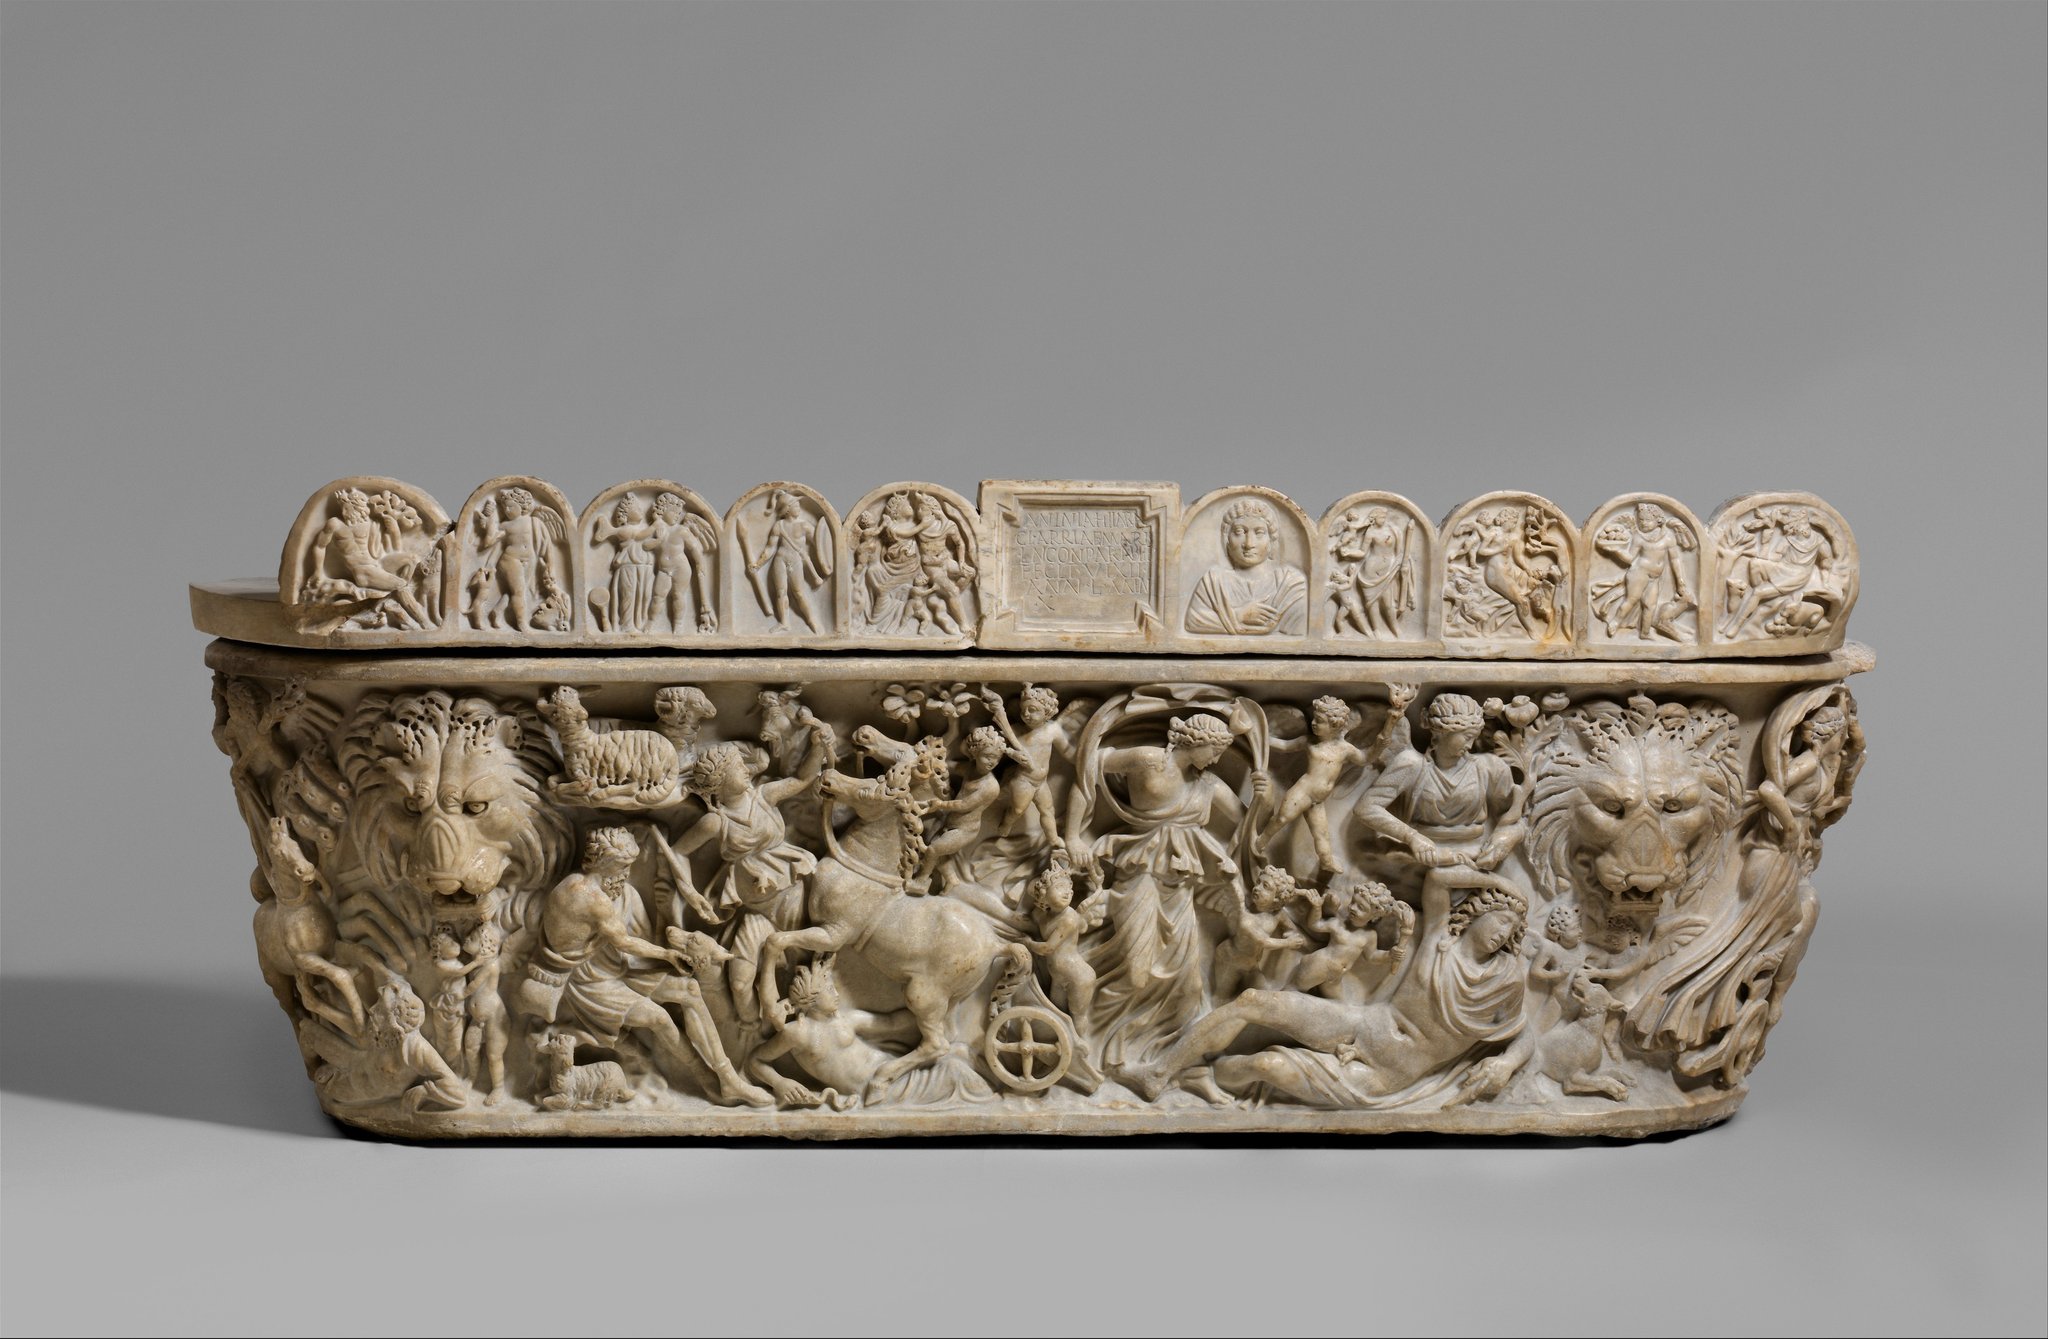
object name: sarcophagus, endymion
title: Marble sarcophagus with the myth of Selene and Endymion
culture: roman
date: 201-233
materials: marble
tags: men,women,eros,bulls,horses,lions,sheep,chariots